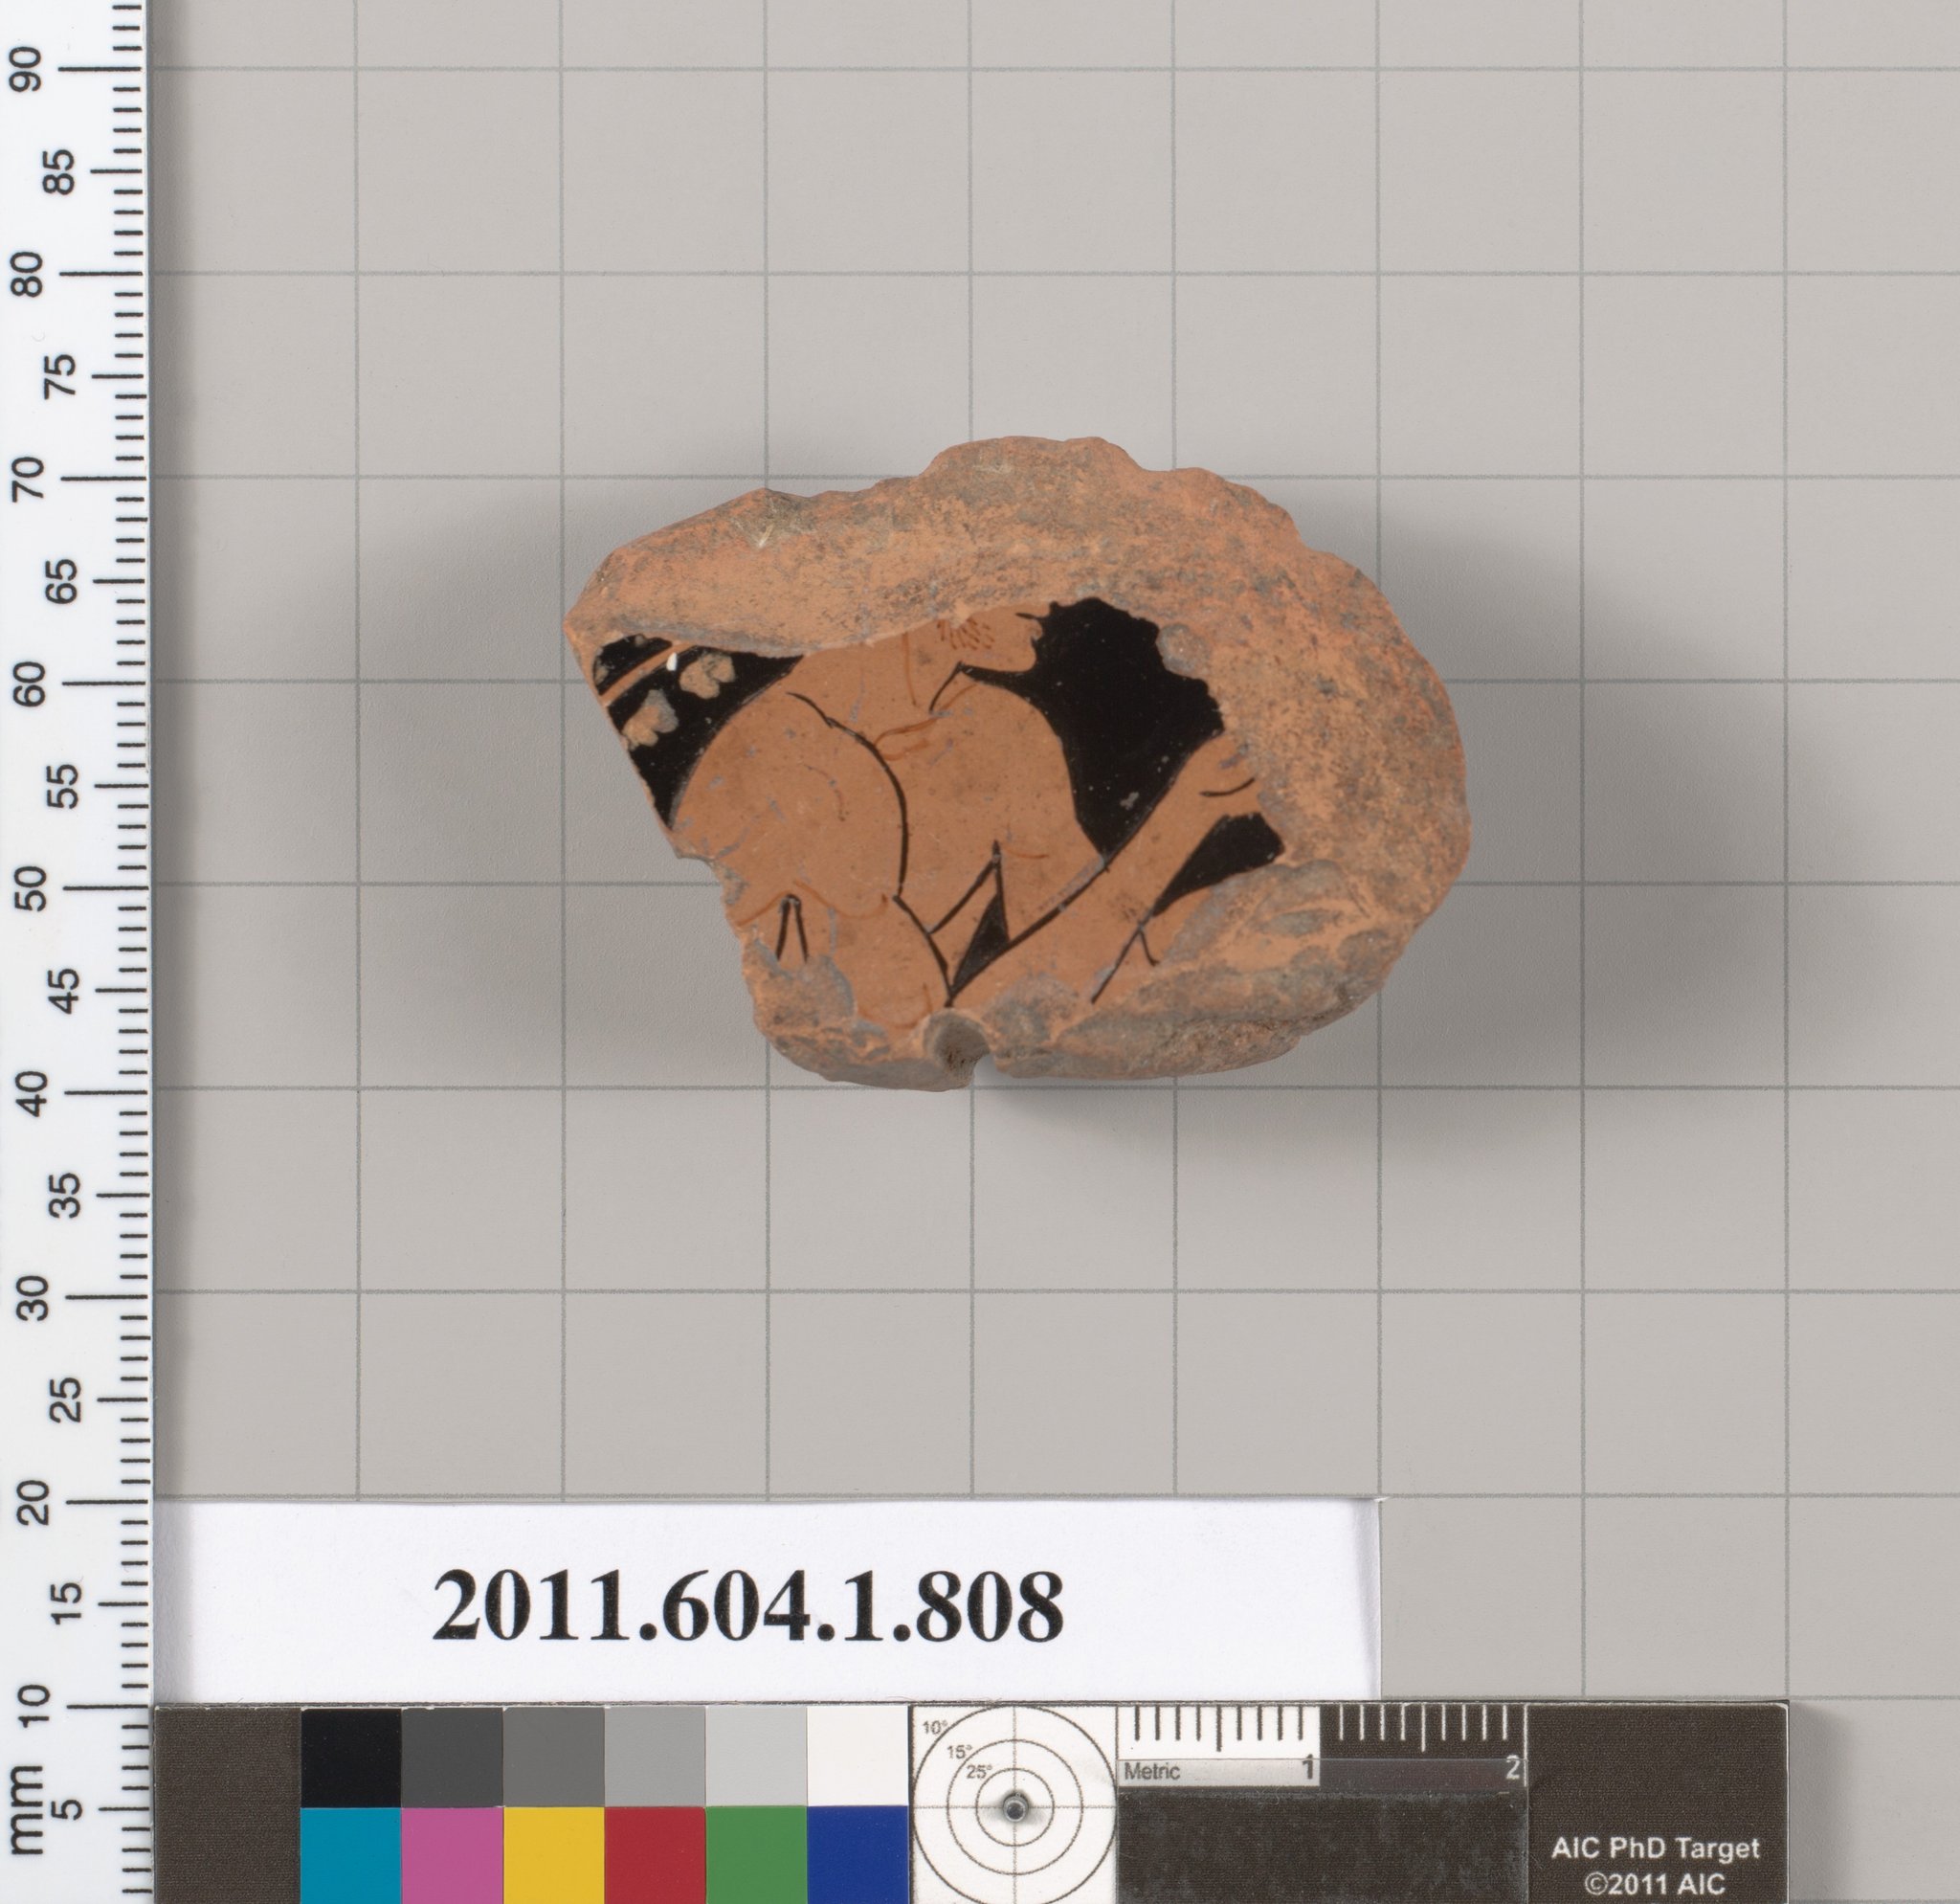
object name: kylix fragment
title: Terracotta fragment of a kylix (drinking cup)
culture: greek, attic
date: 433-567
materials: terracotta